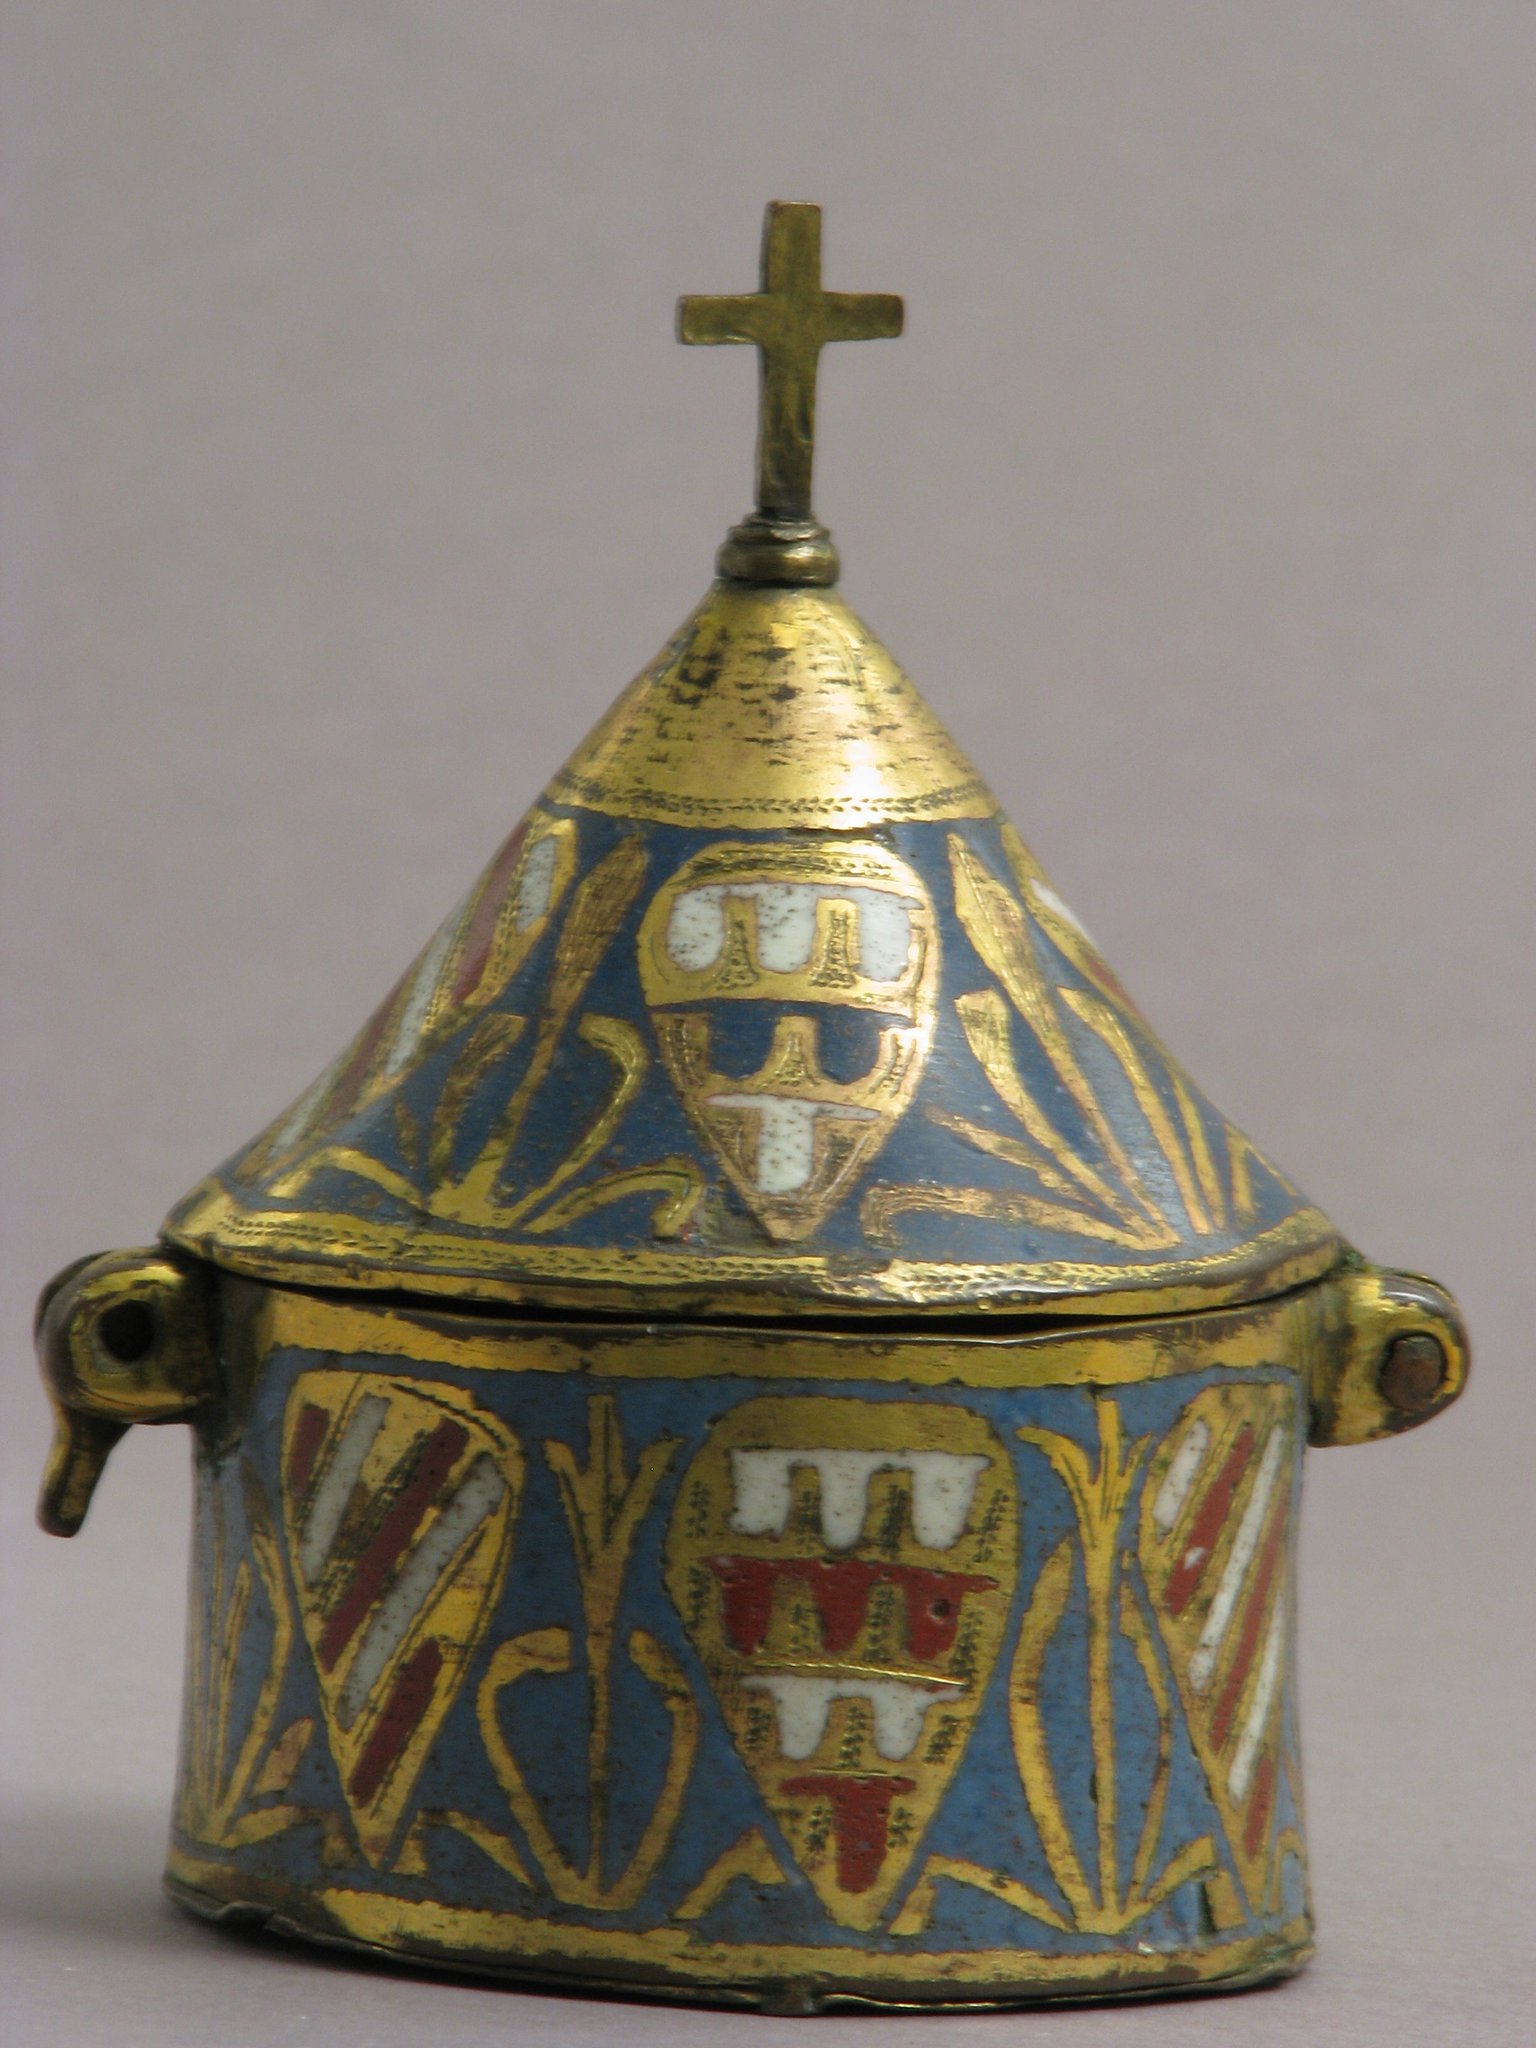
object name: pyx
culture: french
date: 1250-1300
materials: copper, enamel, gilt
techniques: enamel, engraving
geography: france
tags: cross